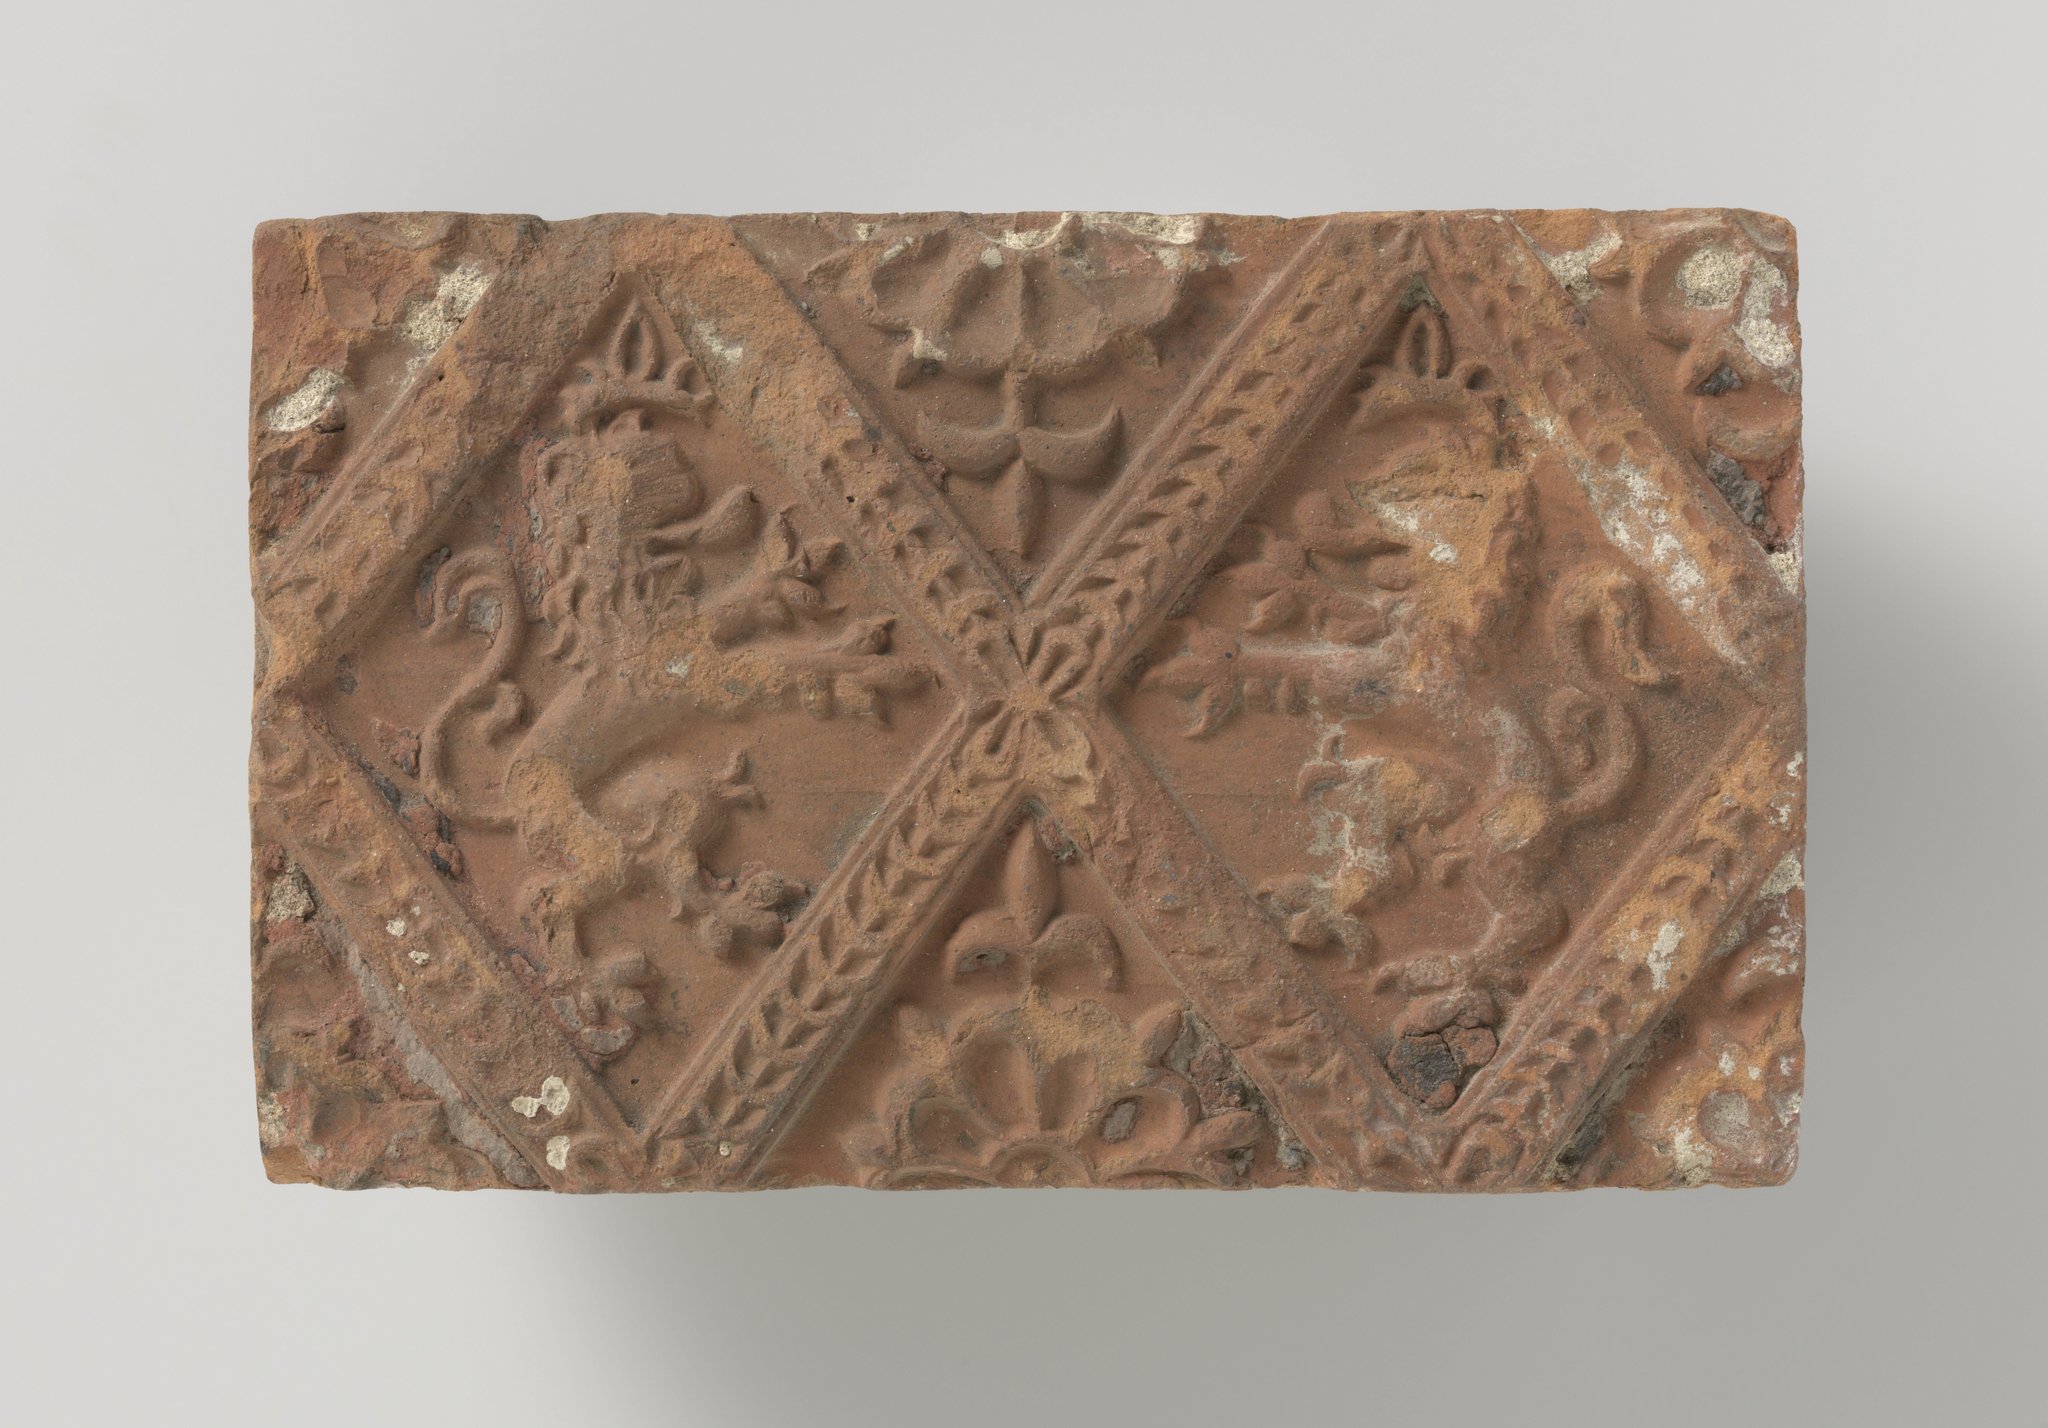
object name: hearthstone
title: Haardsteen met voorstelling van twee klimmende leeuwen, geplaatst in twee ruiten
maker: Anonymous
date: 1575-1625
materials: earthenware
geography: southern netherlands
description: Haardsteen met voorstelling van twee klimmende leeuwen, geplaatst in twee ruiten. De halve ruiten aan de boven- en onderkant zijn opgevuld met ruitvormige bloemen.